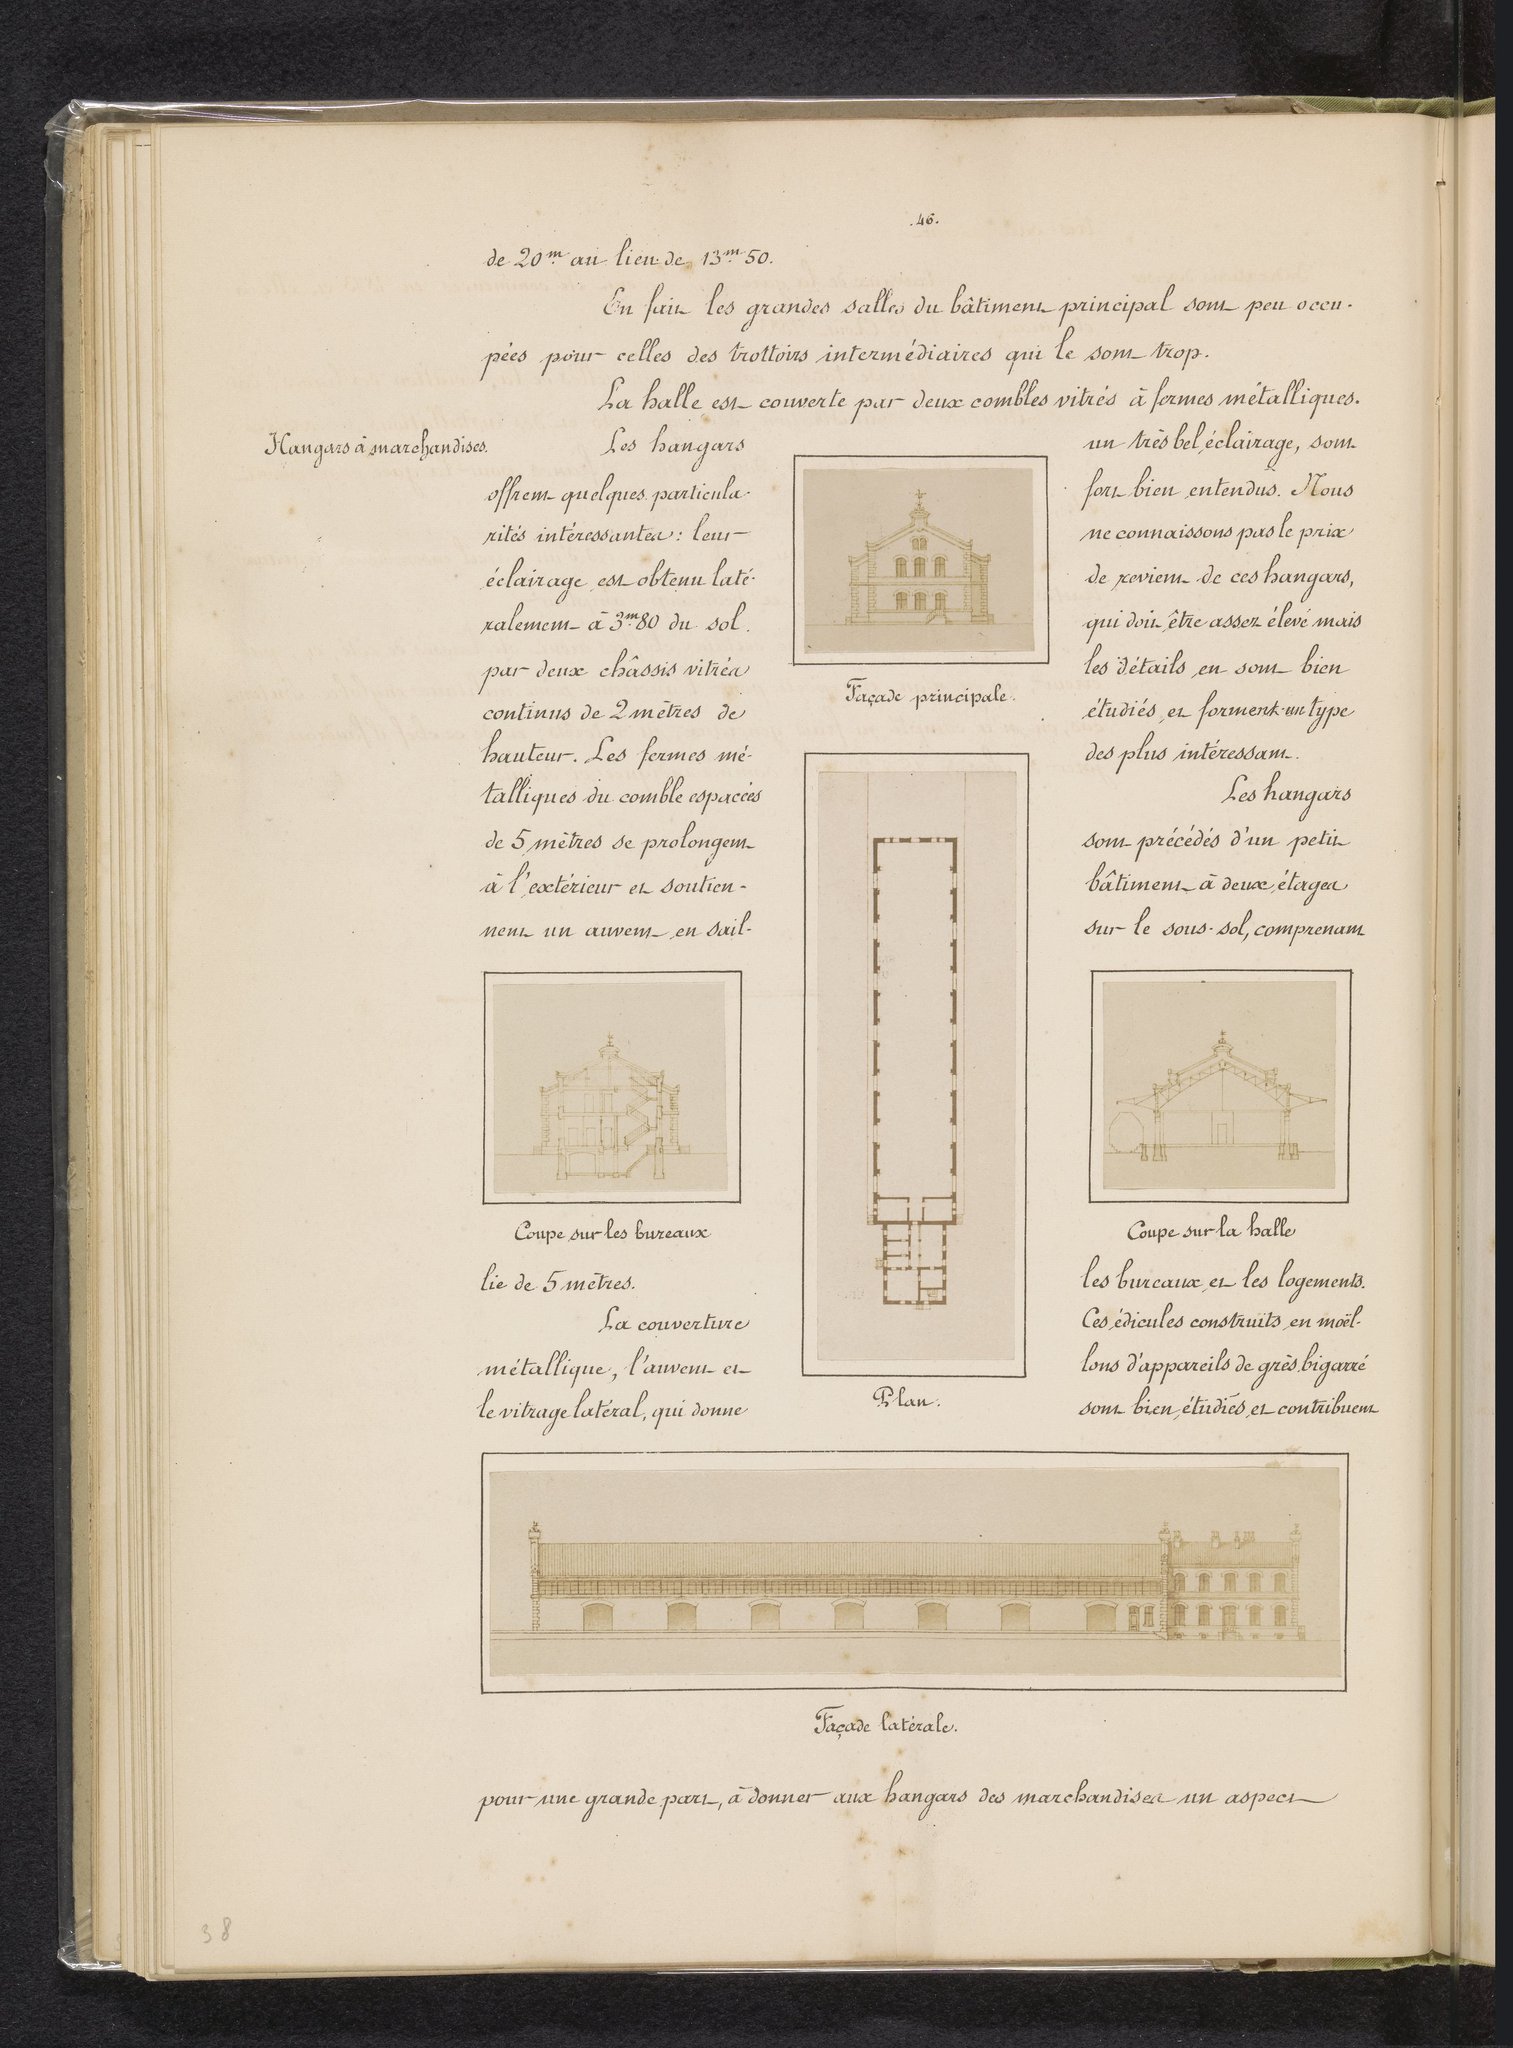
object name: photograph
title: Façade latérale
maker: Anonymous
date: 1874-1884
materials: photographic support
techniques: albumen print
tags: railway, train, façade (of house or building)